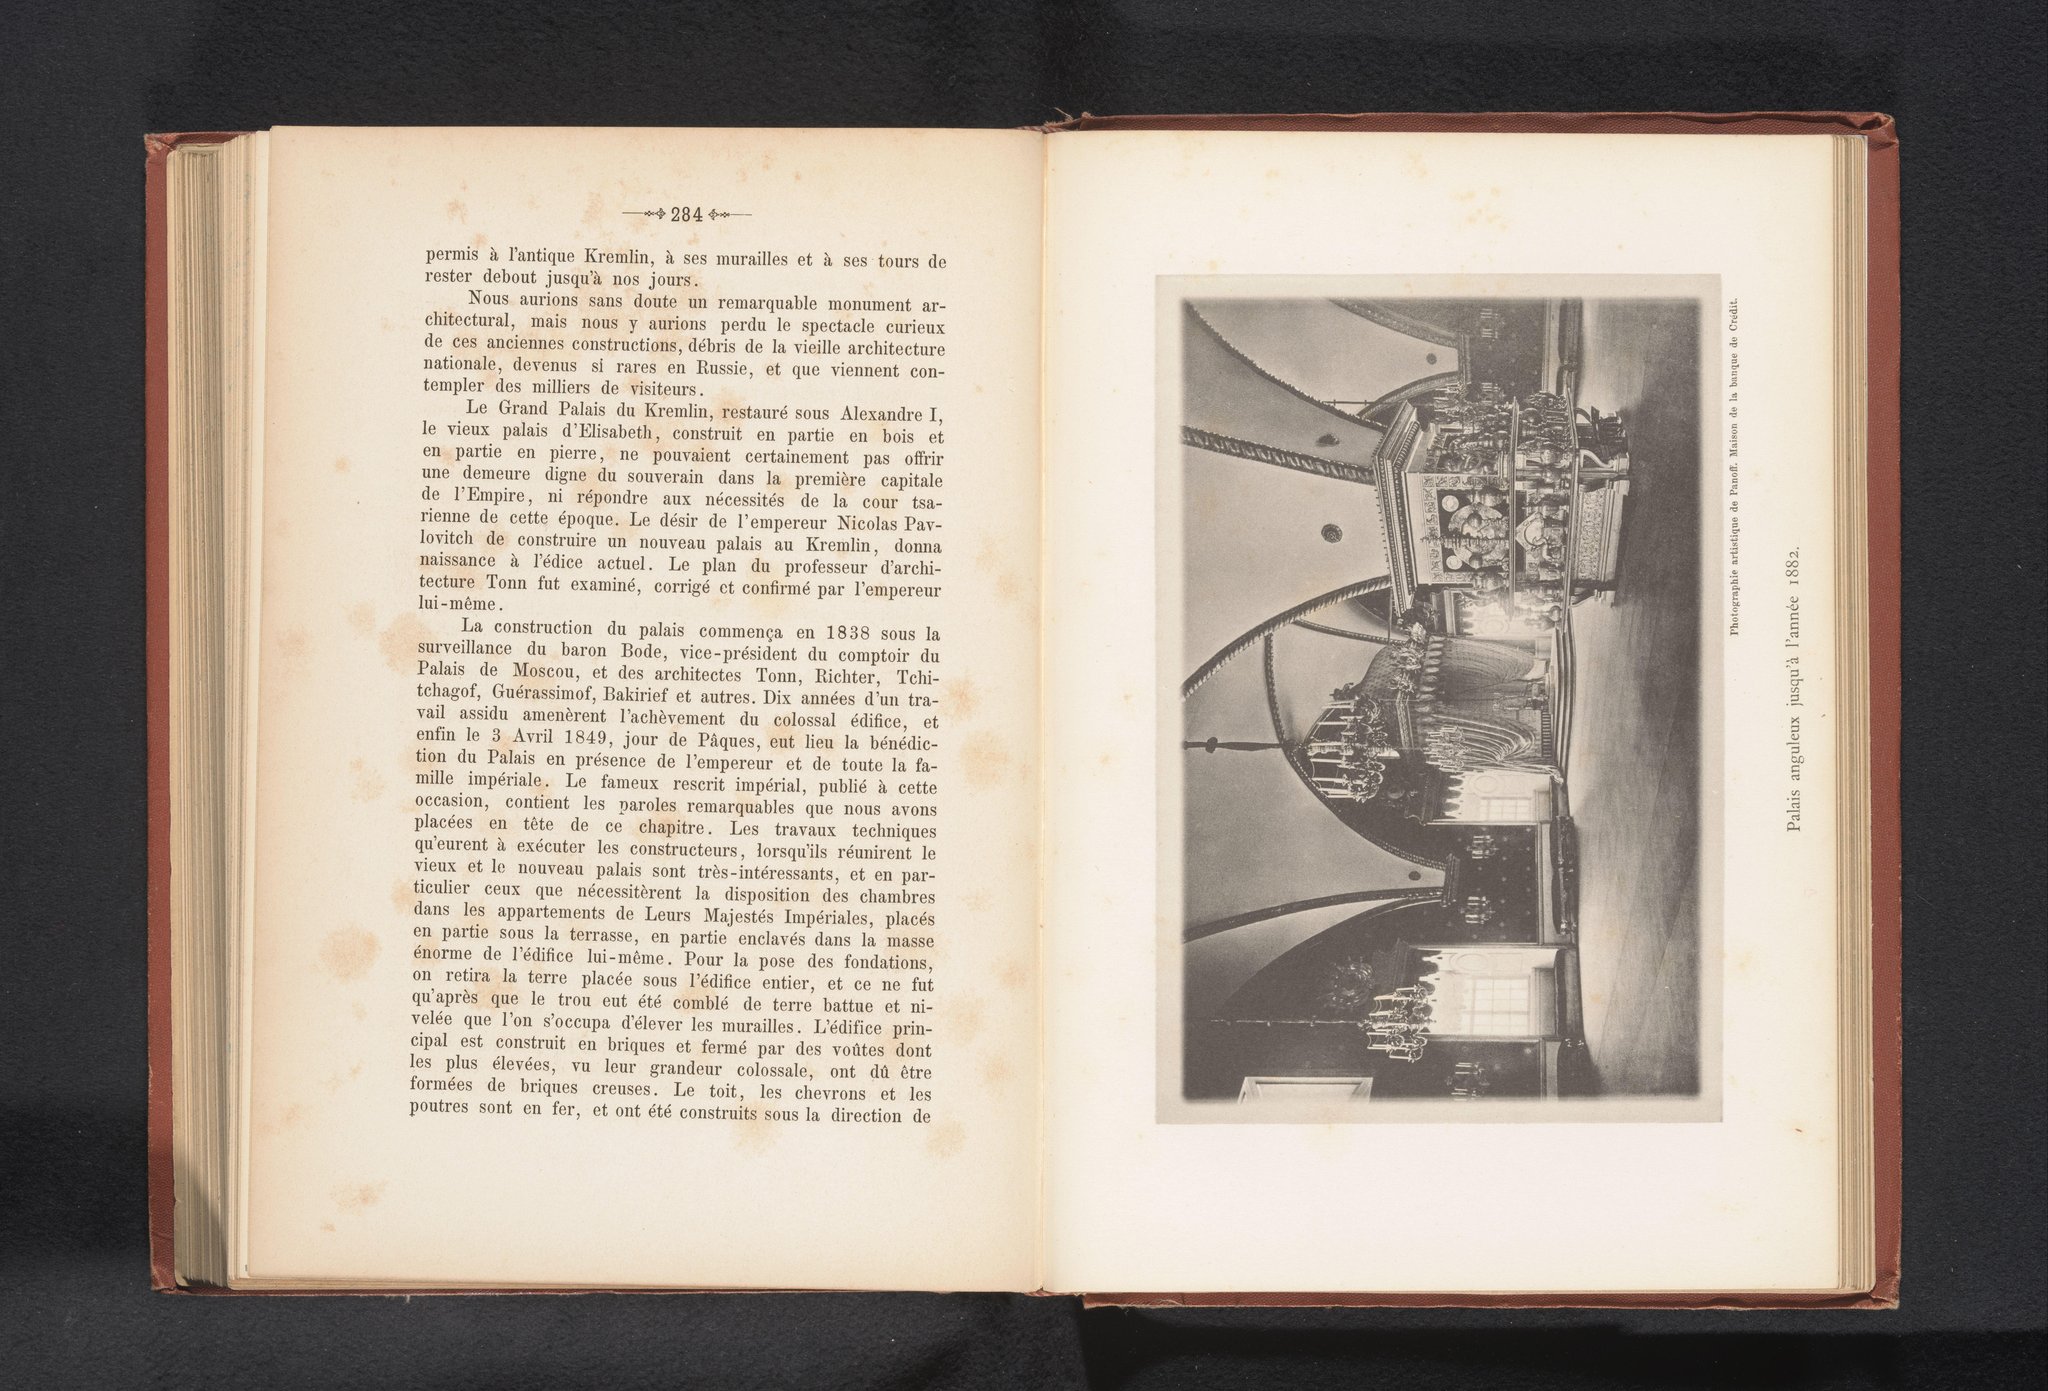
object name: photomechanical print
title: Palais anguleux jusqu'à l'année 1882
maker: Anonymous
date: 1873-1883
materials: paper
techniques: photograph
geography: kremlin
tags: palace, throne-room, wall-covering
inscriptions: name: ‘Photographie artistique de Panoff. Maison de la banque de Crédit.’